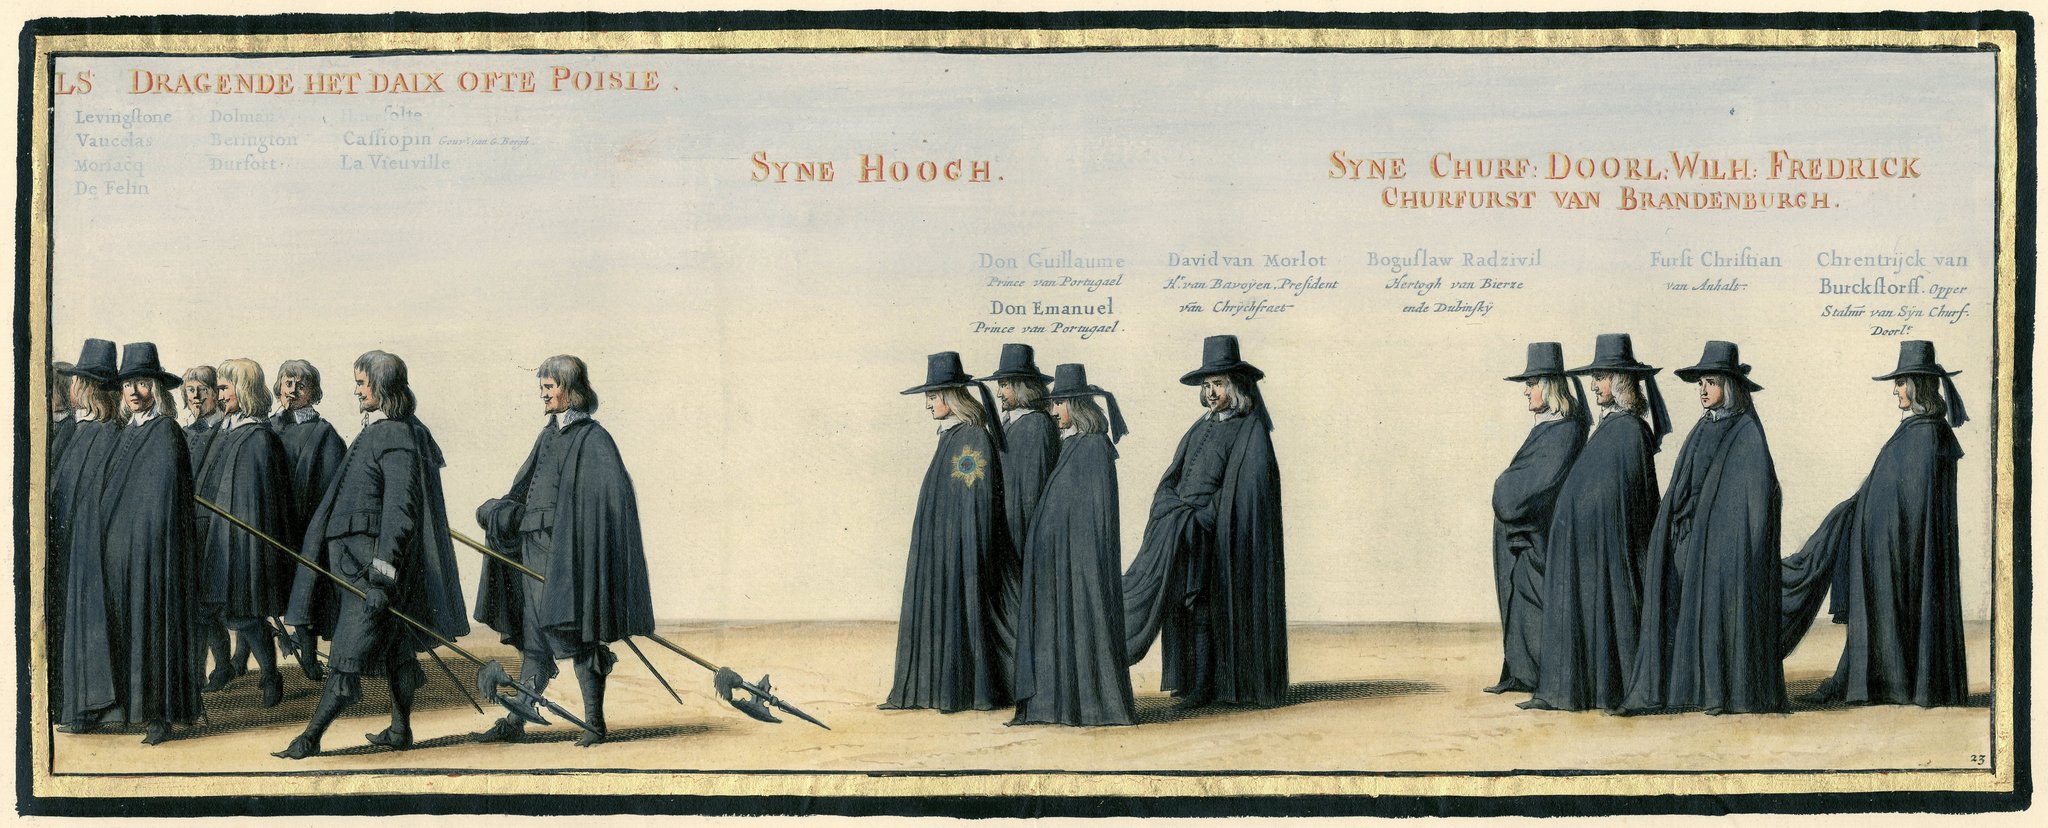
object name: print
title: De begrafenisstoet van Frederik Hendrik, plaat nr. 23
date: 1651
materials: paint, paper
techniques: colour, etching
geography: amsterdam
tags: delft, the hague, frederick henry (prince of orange)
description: De begrafenisstoet van Frederik Hendrik, plaat nr. 23. Ingekleurde prent in een omlijsting versierd met goud en ingeplakt in de luxe editie uit ca. 1755 van het boek 'Begraeffenisse van syne hoogheyt Frederick Henrick' van Pieter Post, uitgegeven te Amsterdam in 1651.